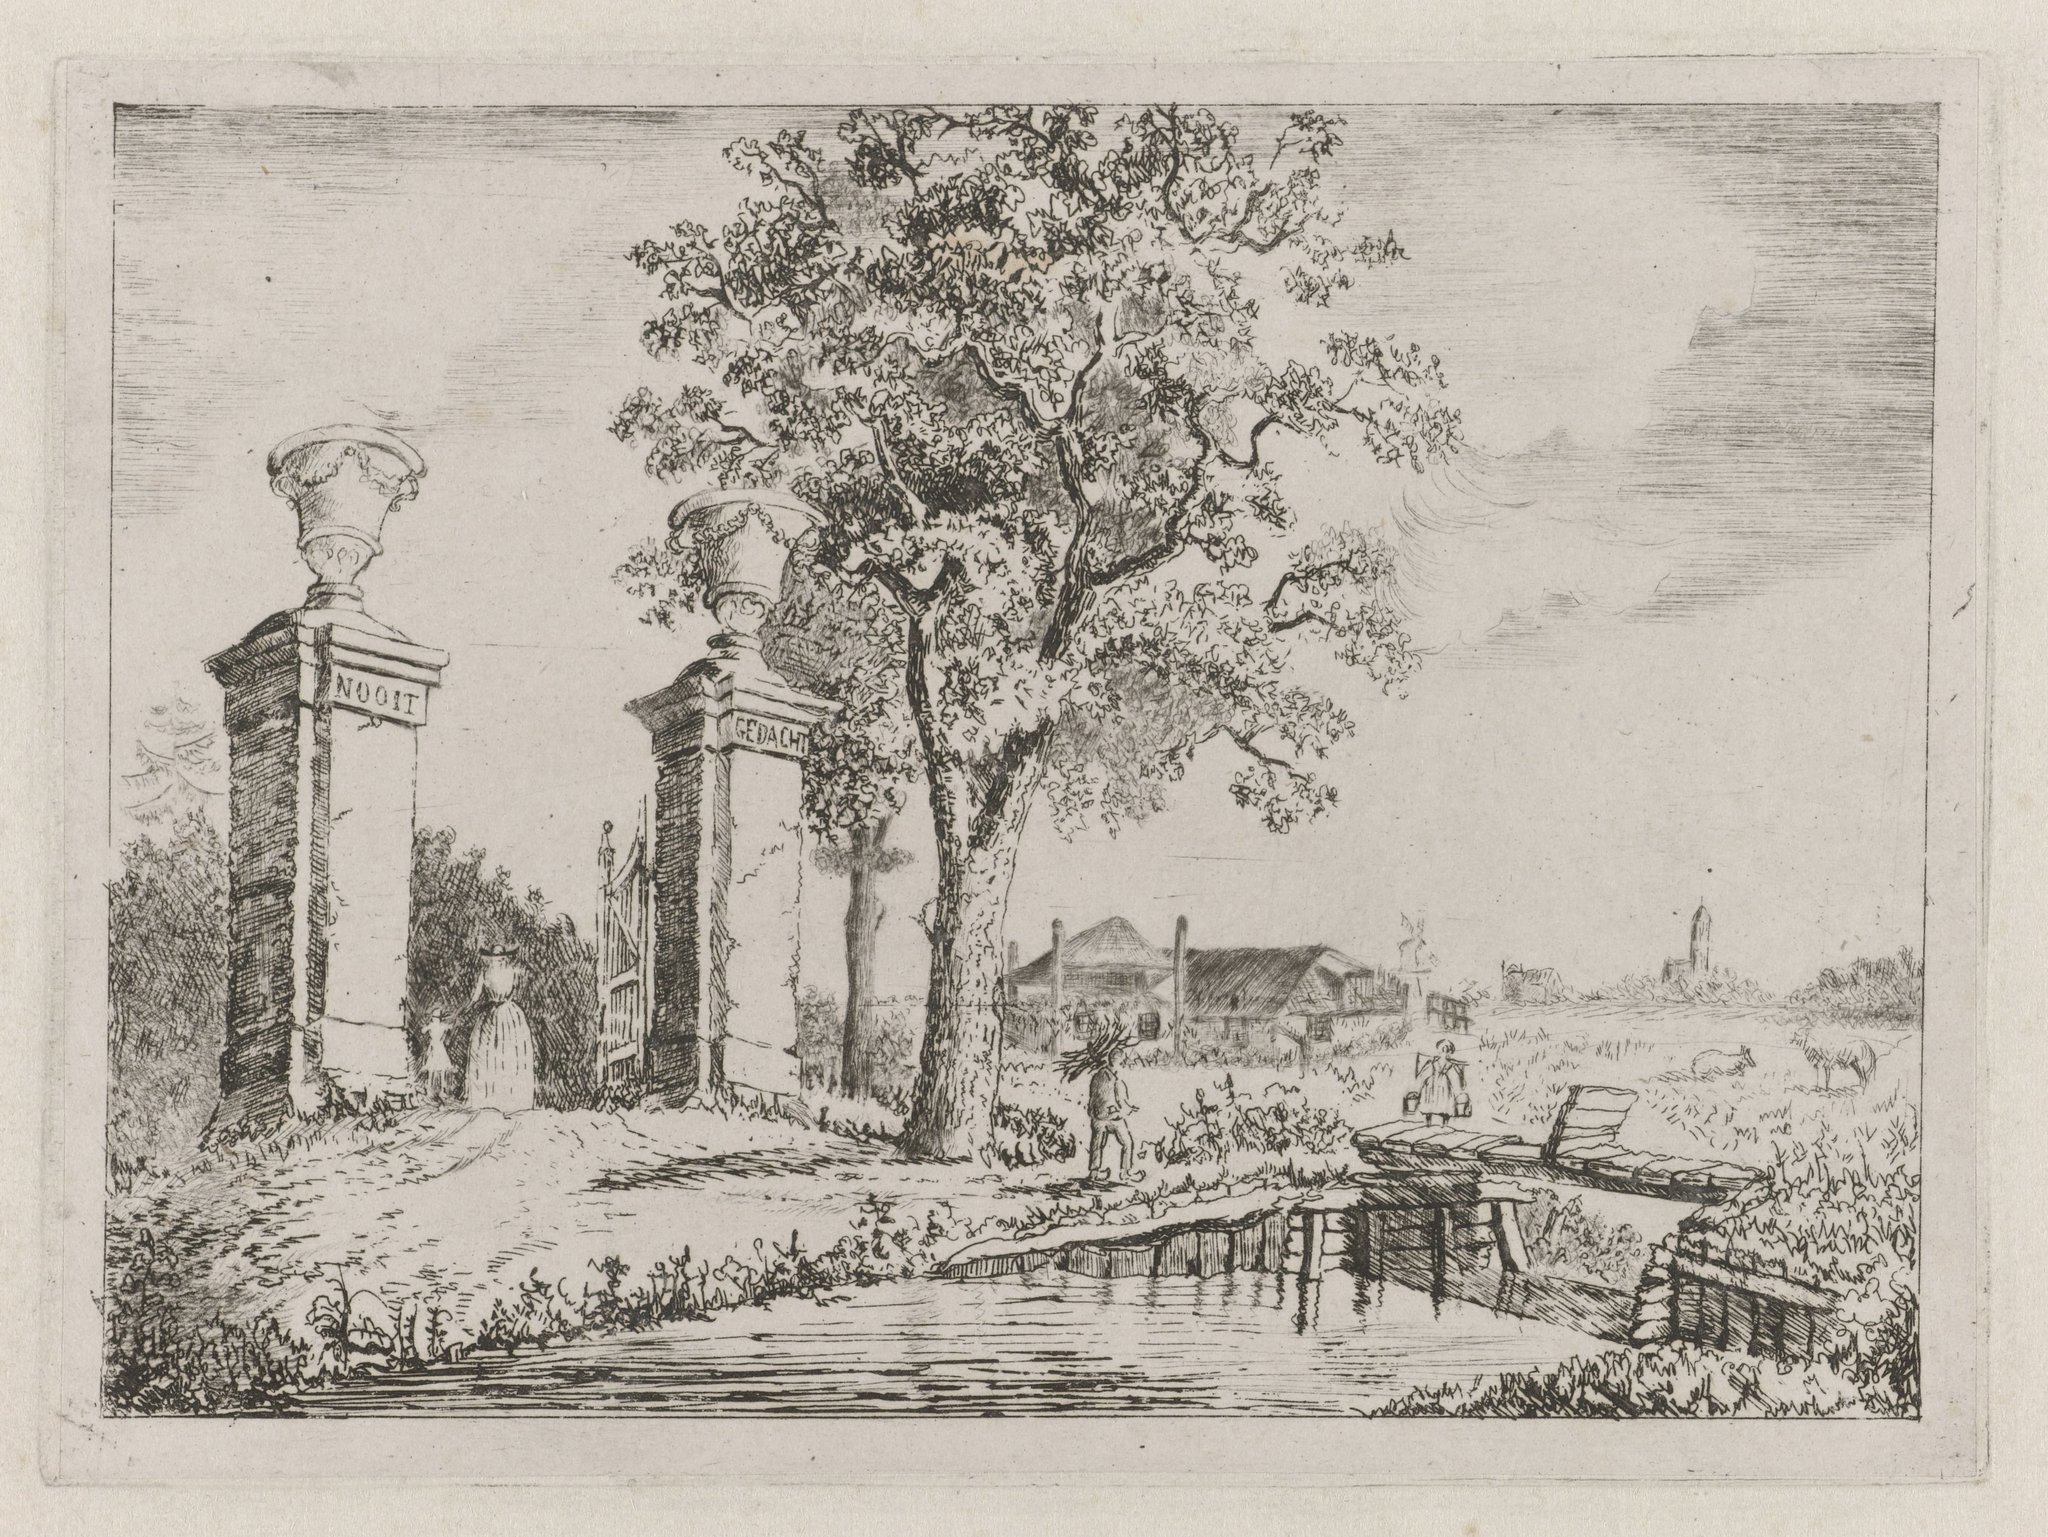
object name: print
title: Ingang van de buitenplaats 'Nooit Gedacht'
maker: eberhard cornelis rahms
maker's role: print maker, publisher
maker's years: 1823-1907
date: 1806-1859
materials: paper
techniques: etching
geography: utrecht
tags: gate, entrance, windmill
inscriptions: inscription: ‘N 1 Koper / De Ingang van een Buitenplaats / Nooit Gedacht / Gedrukt te Utecht op de Plaatdrukkerij / ECR f / Juny 1859 / 3 Staat’, collector's mark: Lugt 2228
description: Ingang van de buitenplaats 'Nooit Gedacht', met op de voorgrond een brug waar een boerin met melkemmers op staat. Bij de ingang van de buitenplaats een vrouw en een kind. Op de achtergrond een boerderij, weilanden met vee en de contouren van een stad.